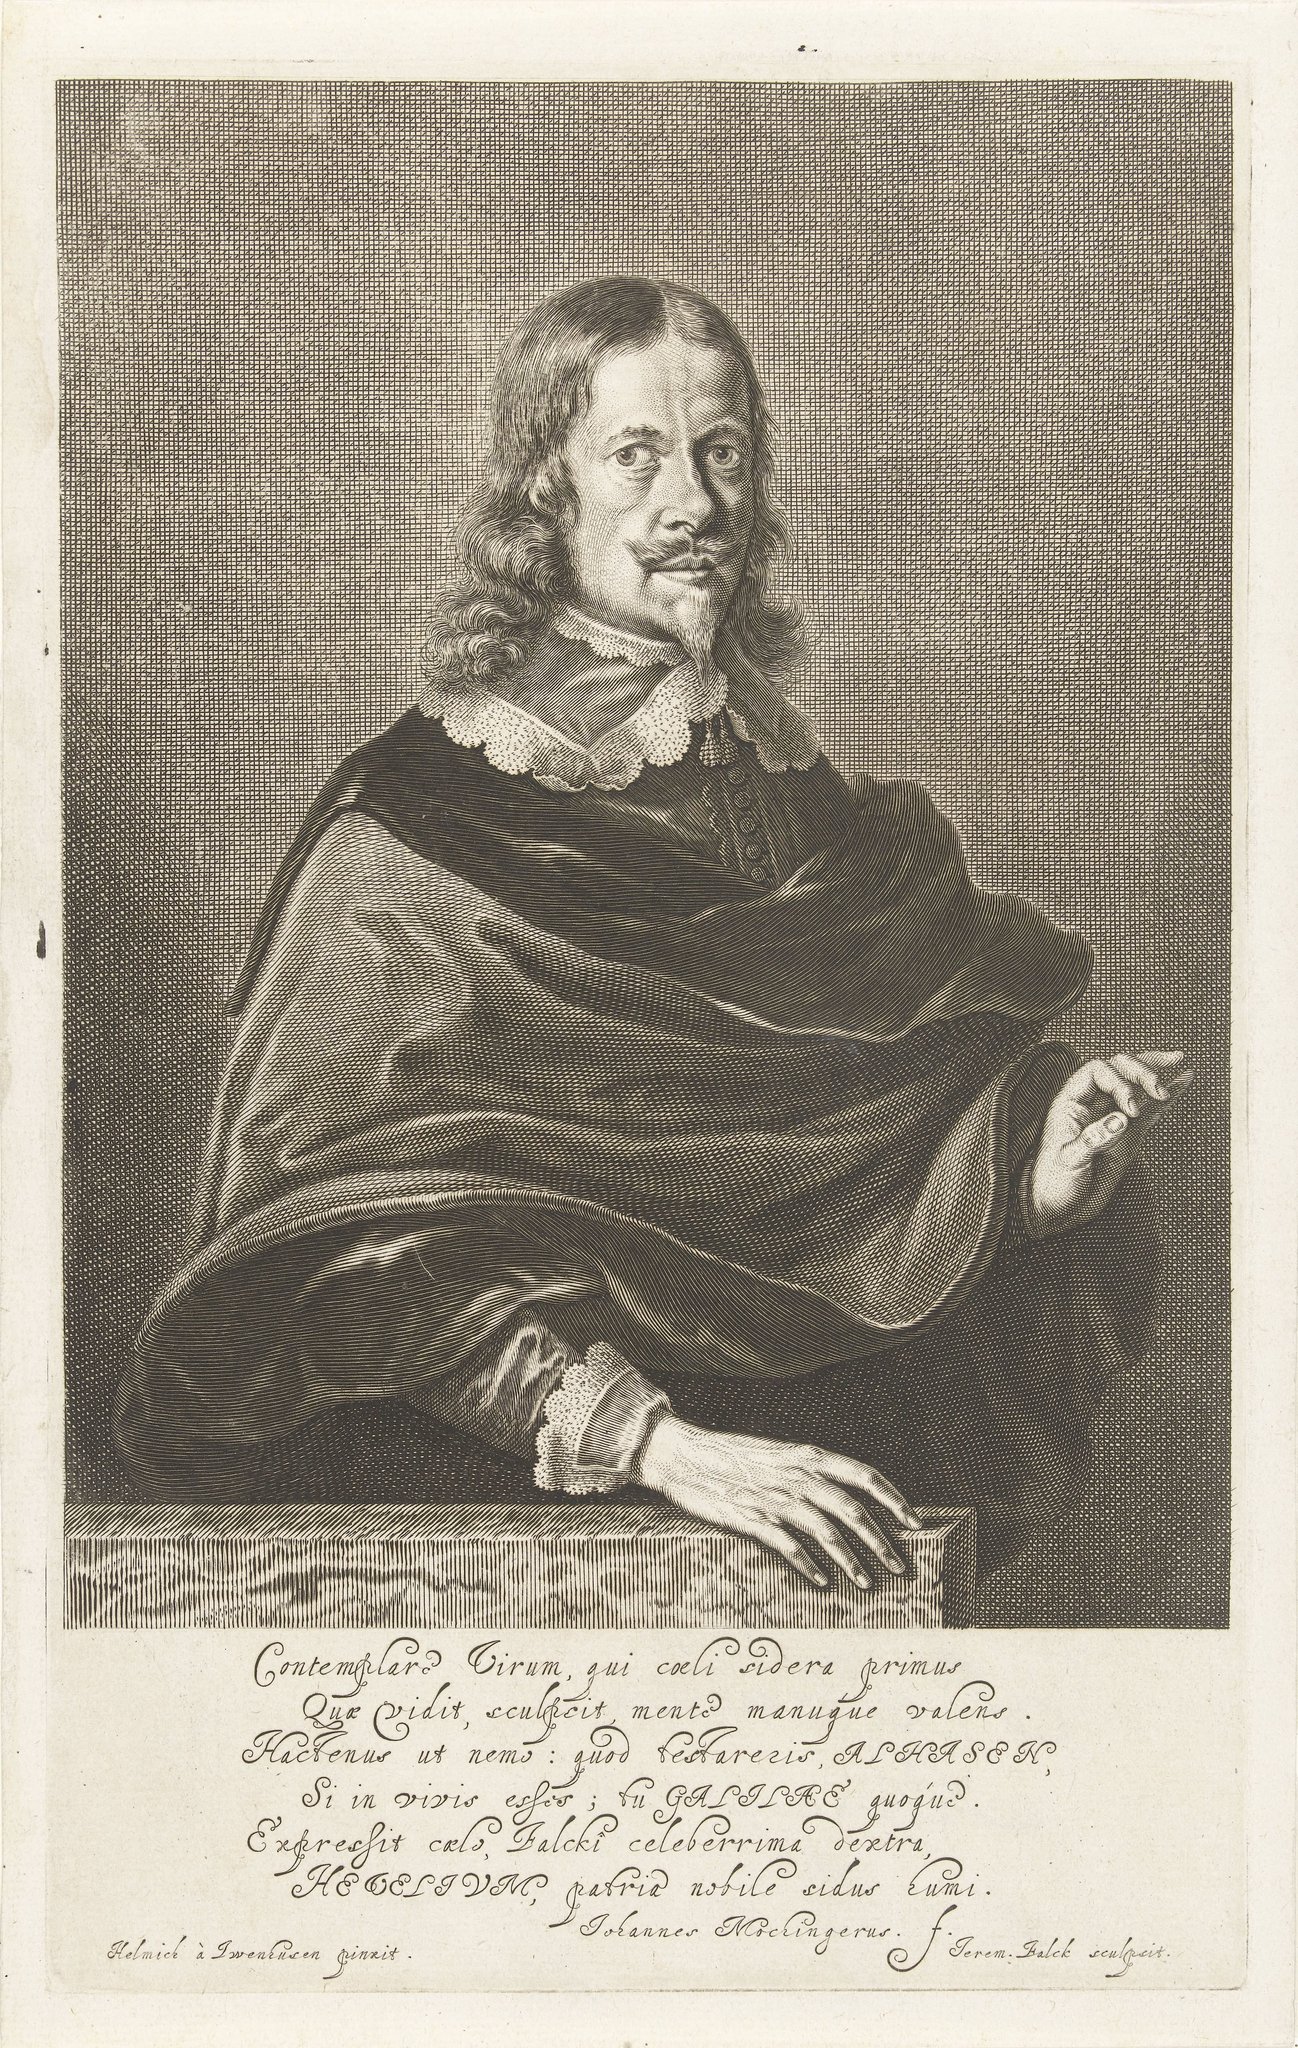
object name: print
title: Portret van Johannes Hevelius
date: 1646-1649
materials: paper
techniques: engraving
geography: danzig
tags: danzig, wiskundige, astronoom, johannes hevelius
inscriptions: collector's mark: Lugt 2228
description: Portret van de Duits-Poolse astronoom Johannes Hevelius, burgemeester van Danzig. Ten halven lijve afgebeeld met zijn rechter hand op een balustrade. Onder de voorstelling een opschrift in Latijn.